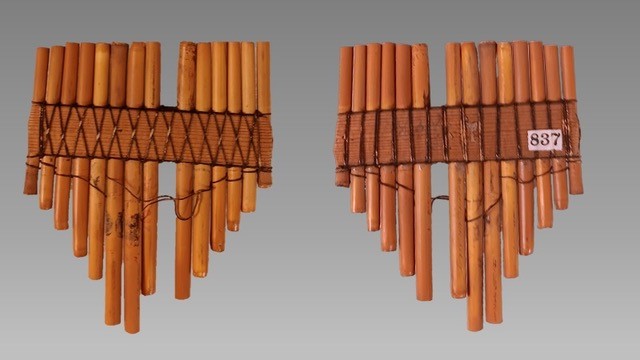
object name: puepava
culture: melanesian, aneityum island or vanuatu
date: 1867-1900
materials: wood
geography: vanuatu